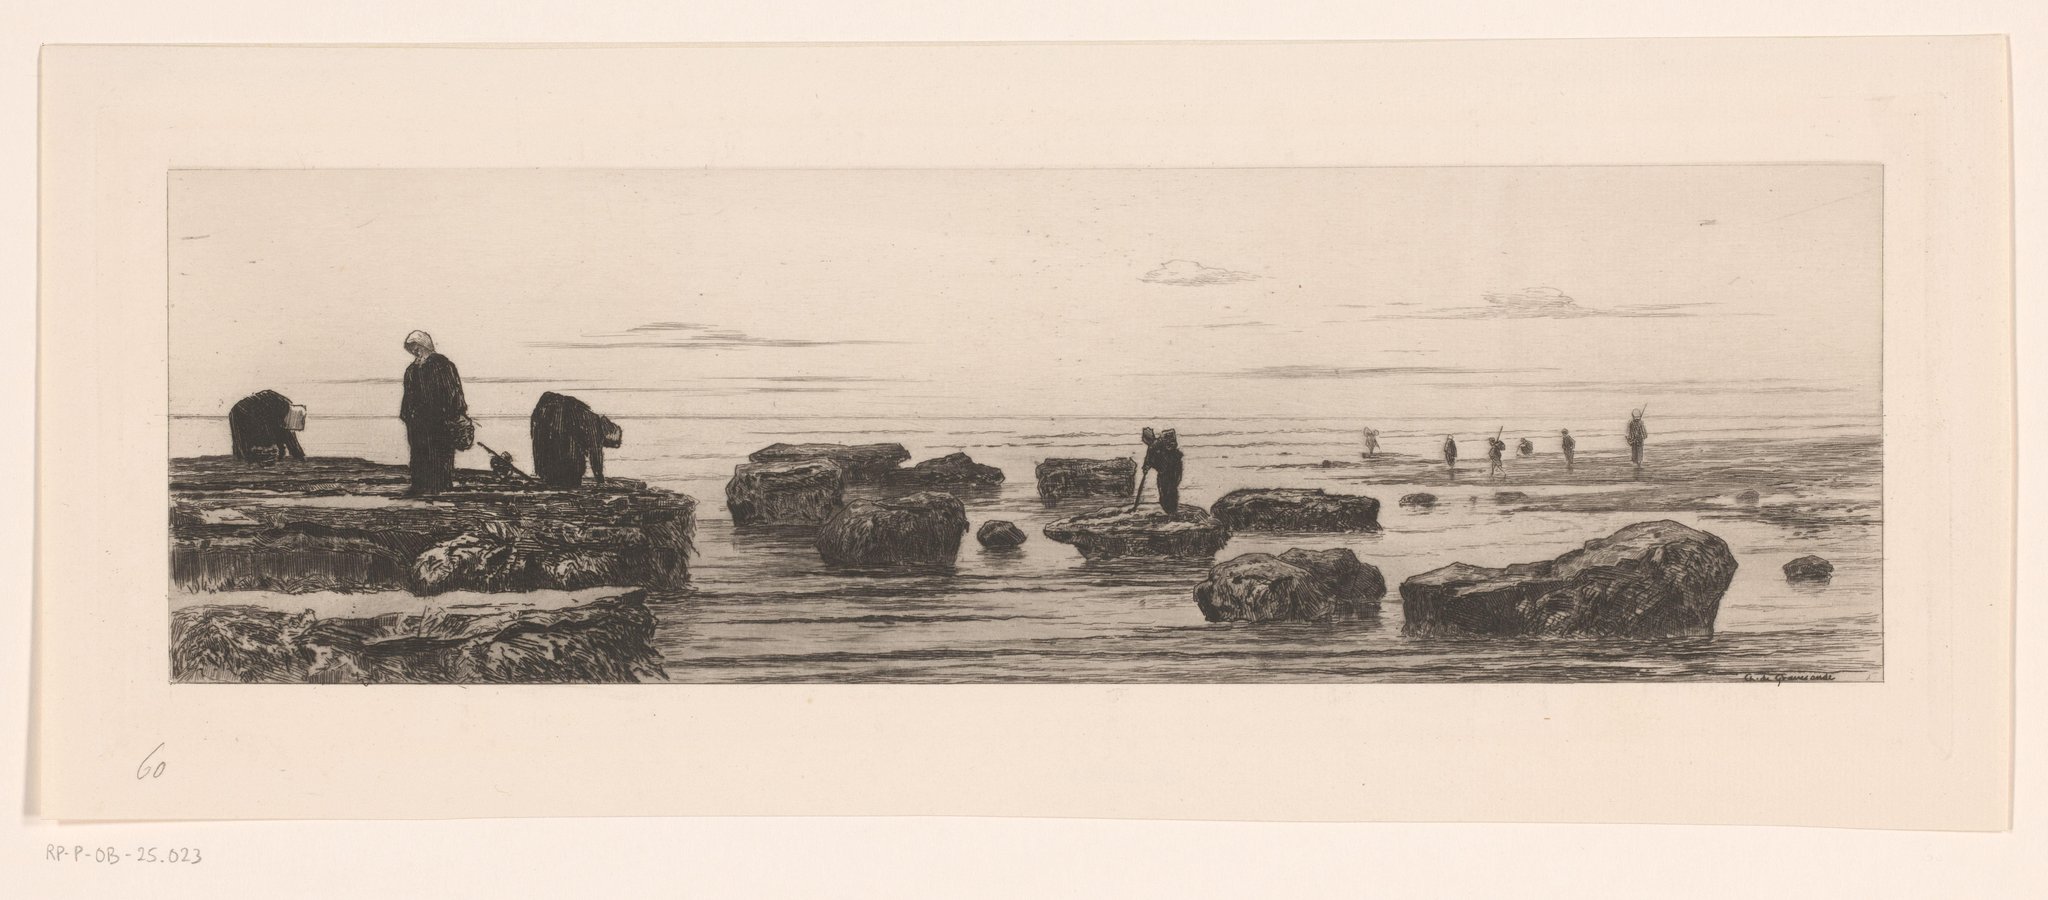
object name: print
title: Zeewierplukkers aan de kust bij Veules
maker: carel nicolaas storm van s-gravesande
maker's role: draughtsman, print maker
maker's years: 1841-1924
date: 1873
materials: paper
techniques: etching, intaglio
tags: gathering herbs, beach (+ landscape with figures, staffage)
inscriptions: collector's mark: Lugt 2228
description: Gezicht op een strand met rotsblokken waar mensen zeewier aan het plukken zijn in de branding.